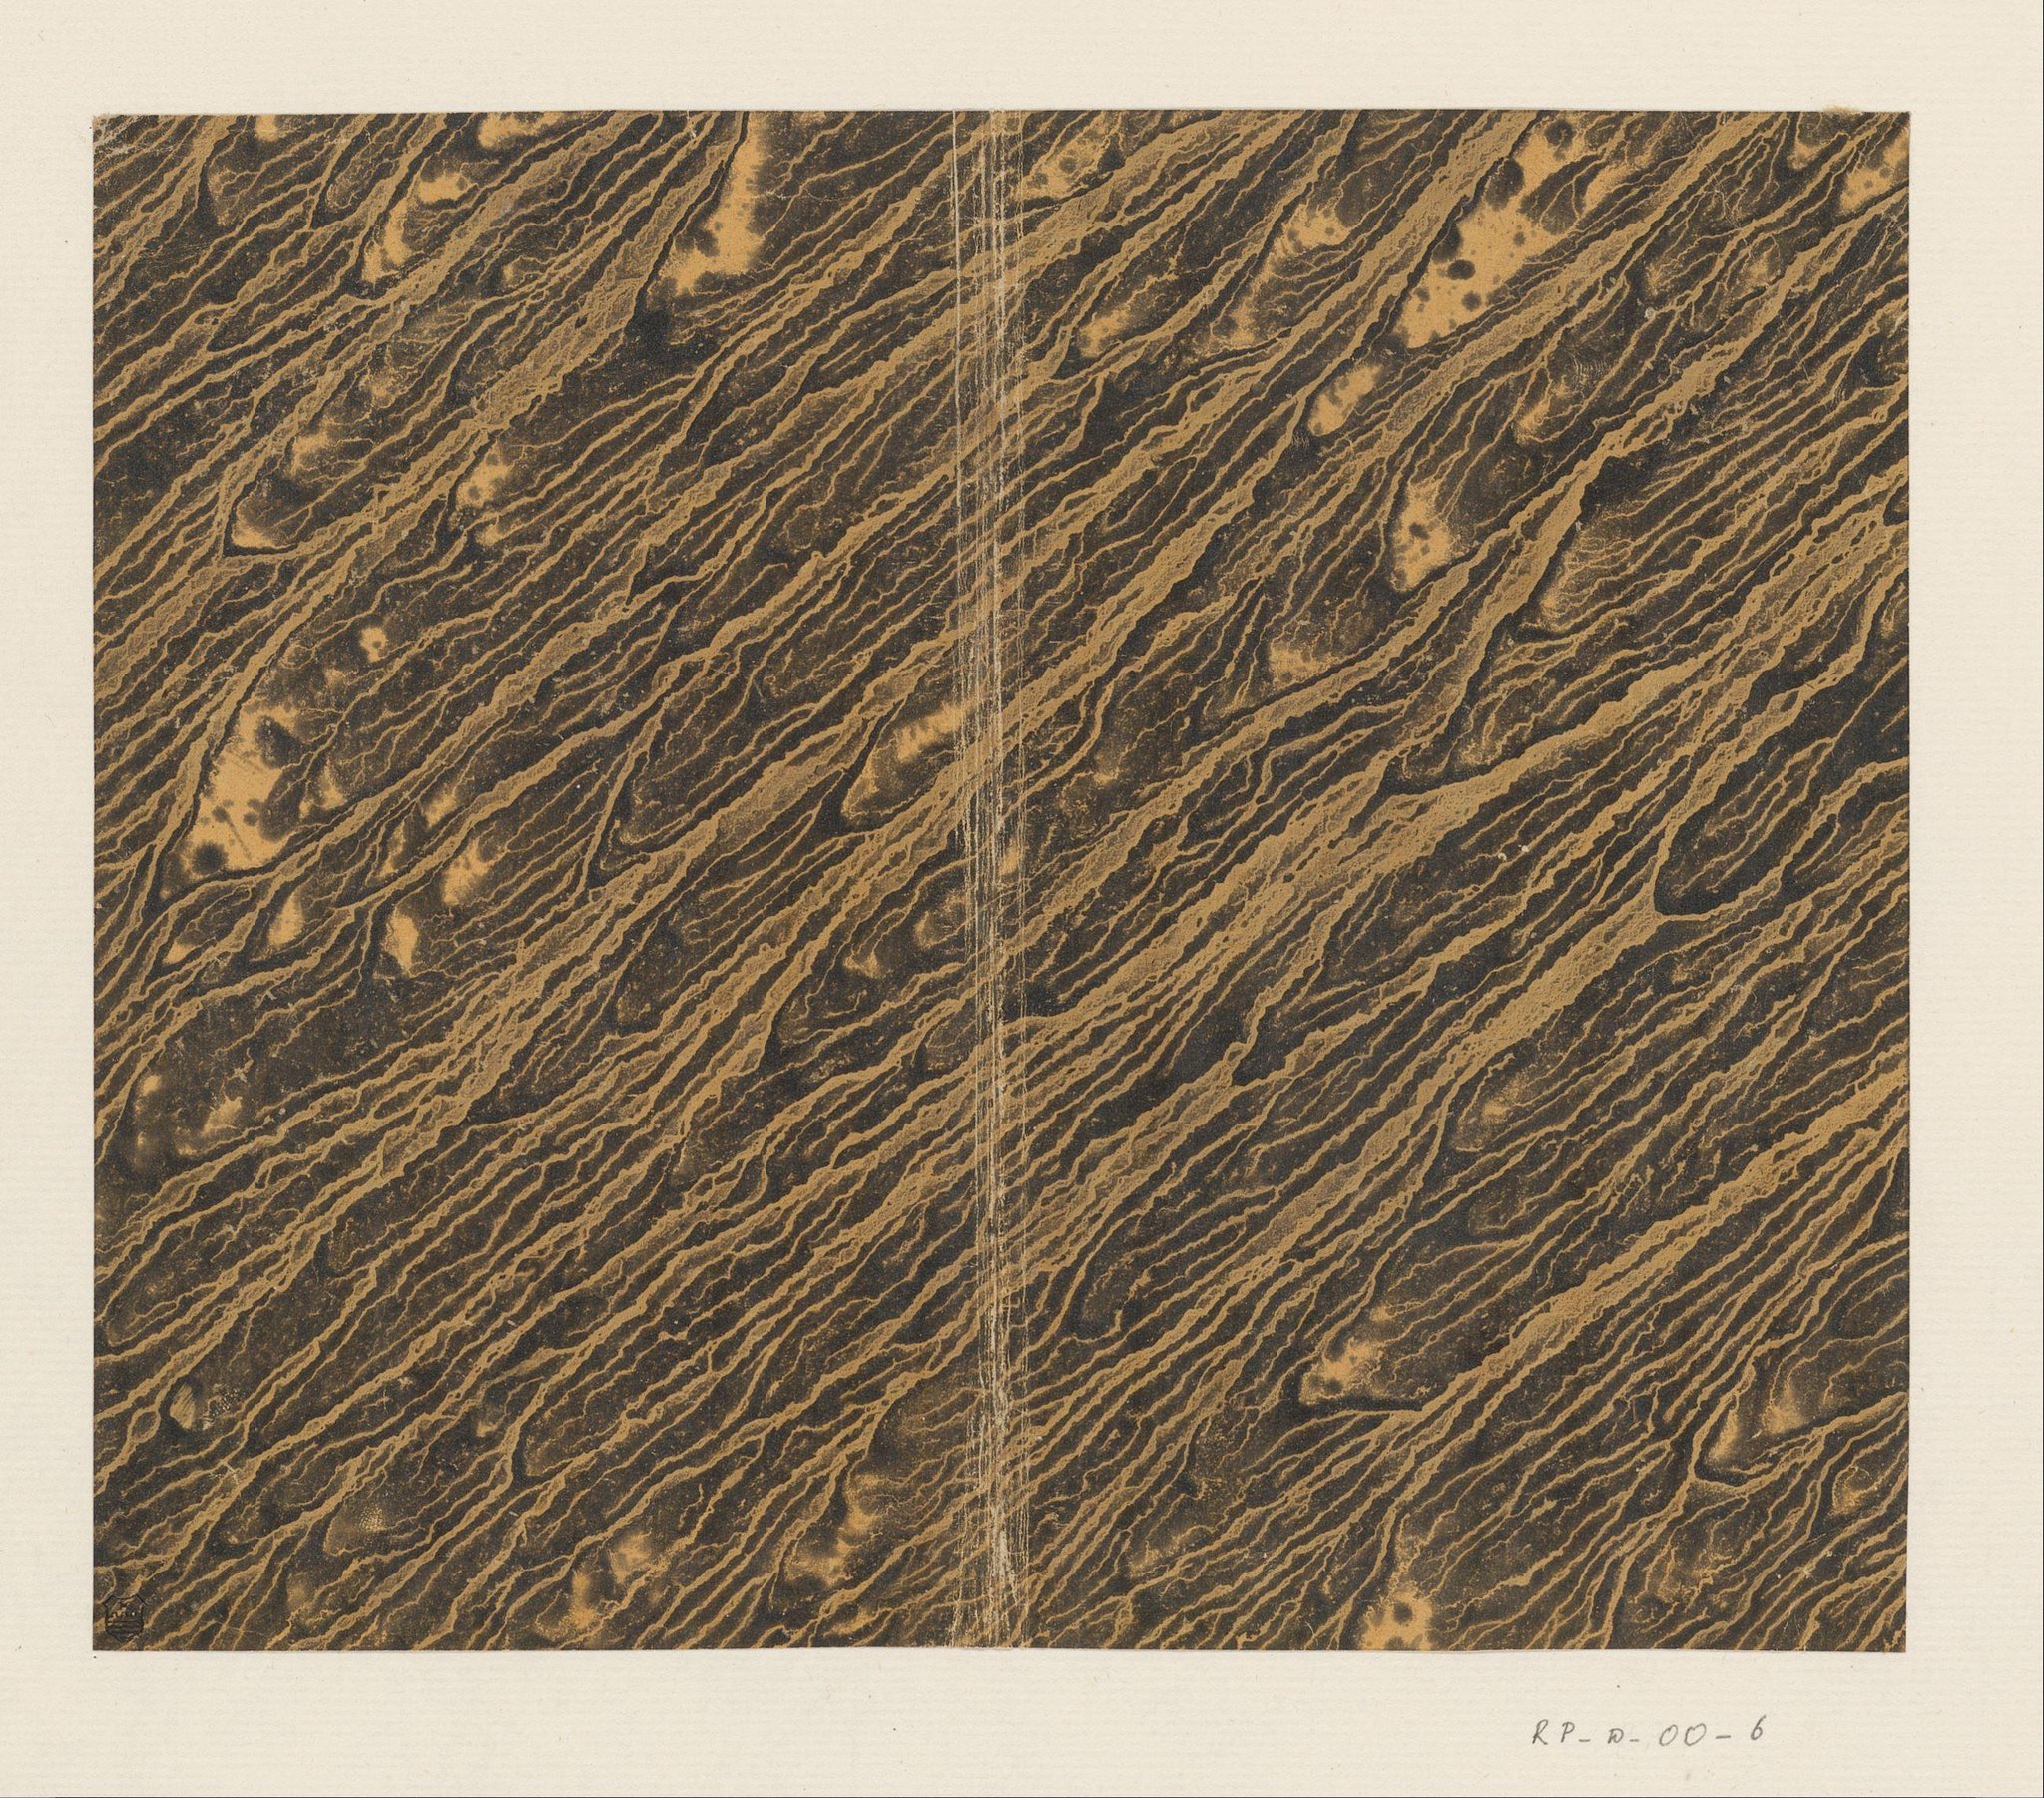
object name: wrapper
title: Stroommarmer in zwart op geel papier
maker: Anonymous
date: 1850-1917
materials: paper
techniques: marbling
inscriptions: collector's mark: Lugt 2760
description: Stroommarmer in zwart op geel papier. Gebruikt als omslag.